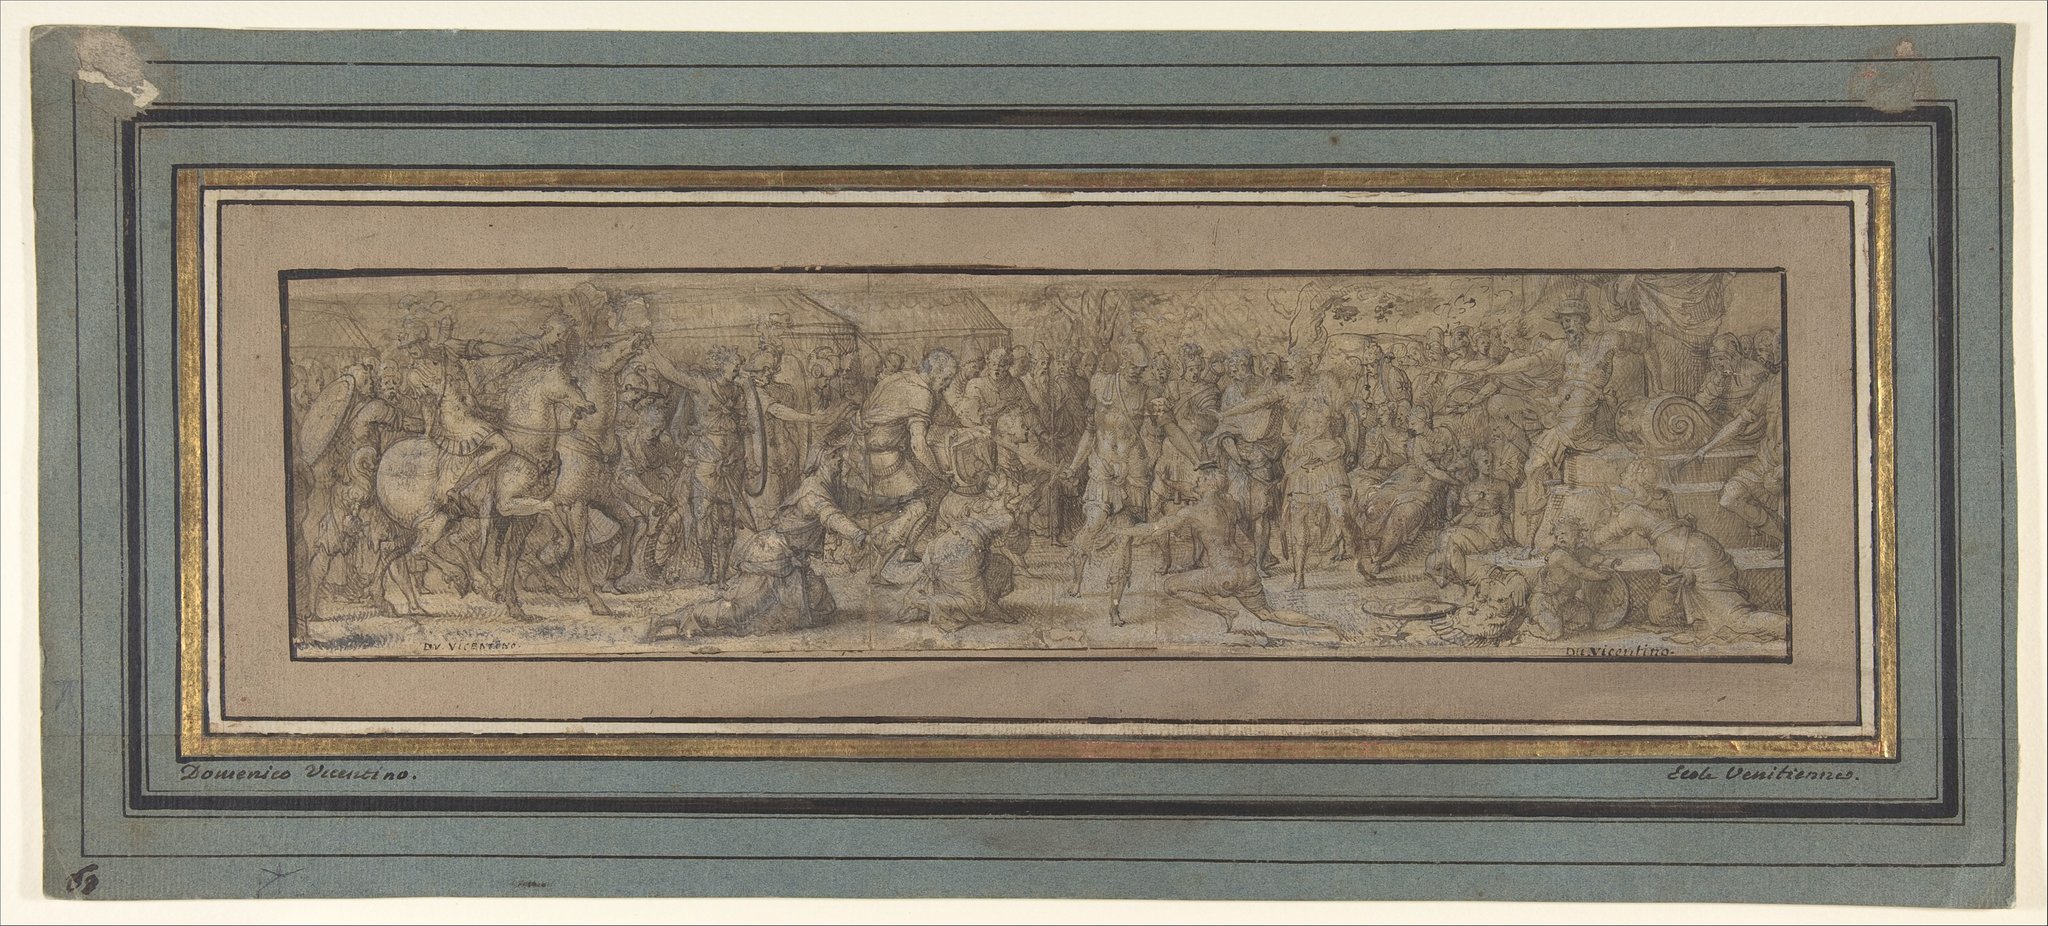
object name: drawing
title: Cassandra preventing Deiphobe from killing Paris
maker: jean cousin the elder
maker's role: artist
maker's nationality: french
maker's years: 1485-1565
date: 1501-1600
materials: chalk, ink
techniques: brush, heightening, pen, wash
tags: men,women,horses,crowd